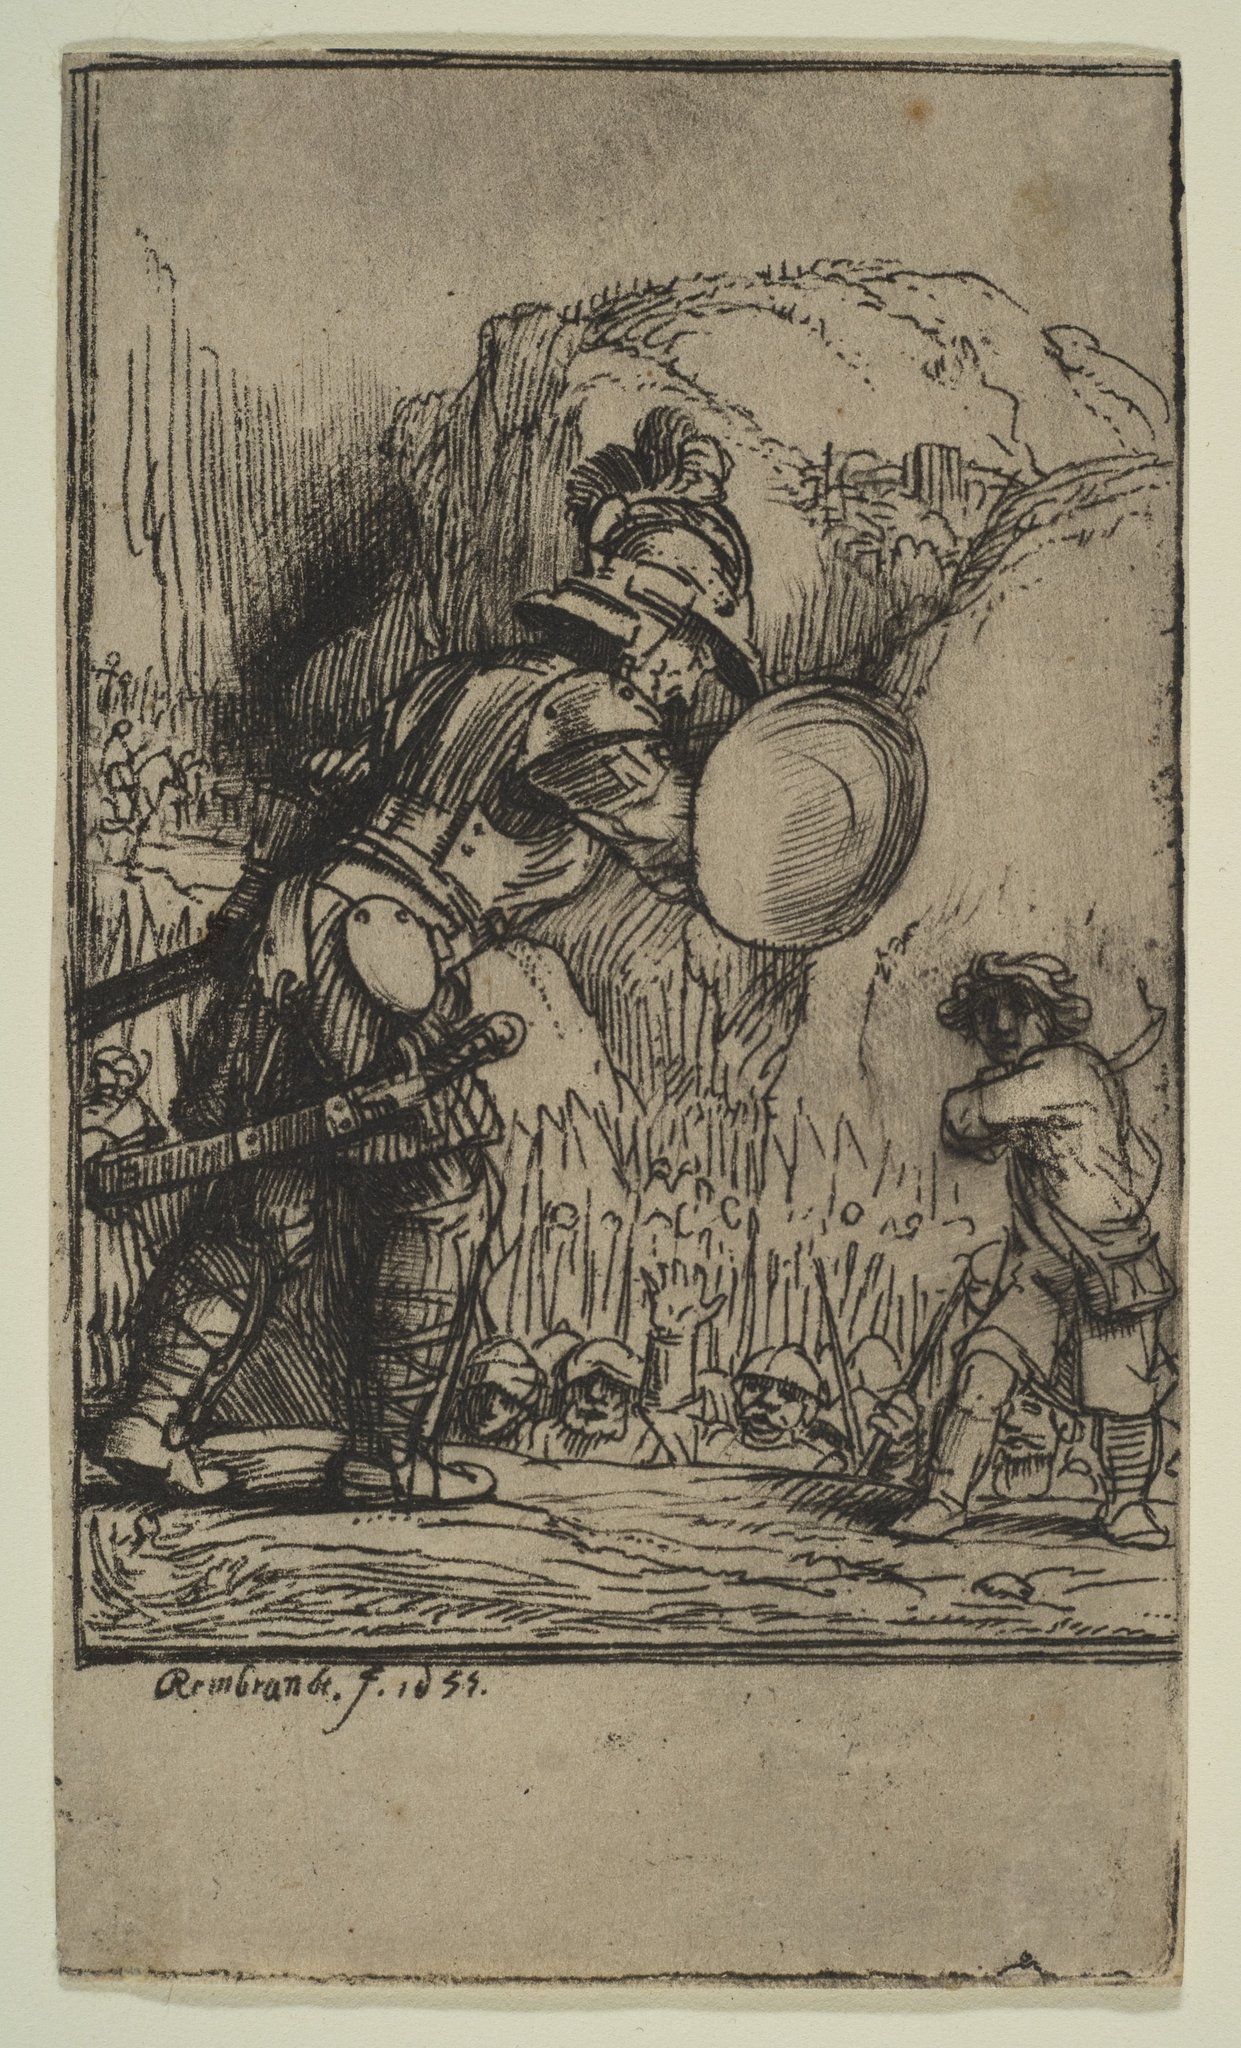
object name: print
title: David and Goliath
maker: rembrandt van rijn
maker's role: artist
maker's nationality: dutch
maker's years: 1606-1669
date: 1655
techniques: engraving, drypoint, etching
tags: shields,weapons,david